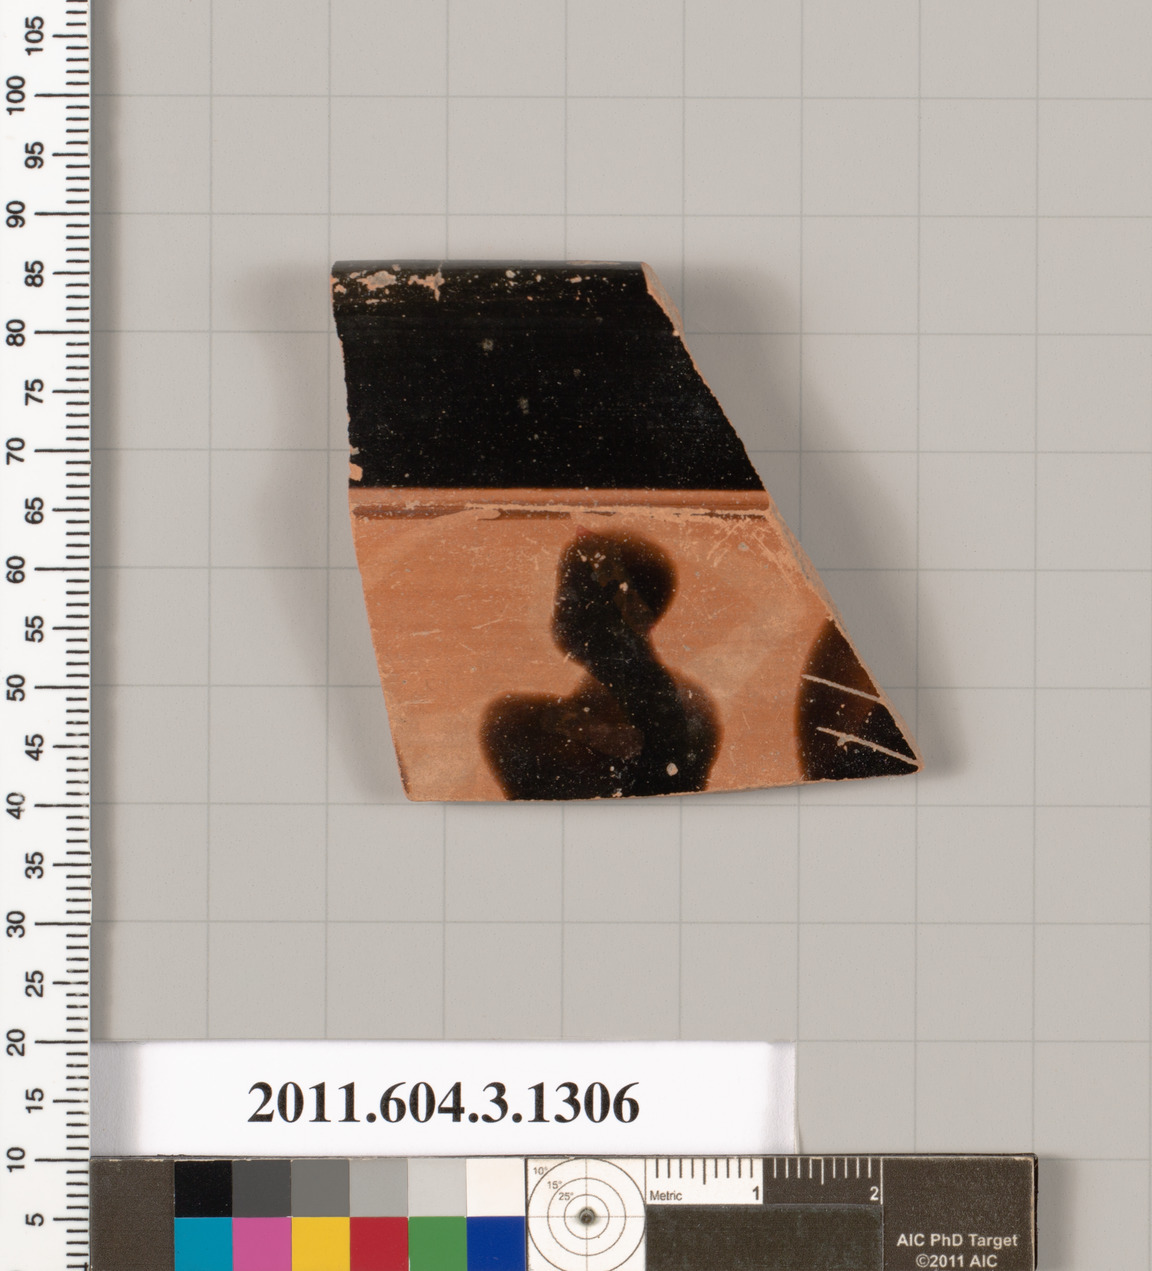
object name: skyphos fragment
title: Terracotta rim fragment of a skyphos (deep drinking cup)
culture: greek, attic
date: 490-480 BCE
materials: terracotta